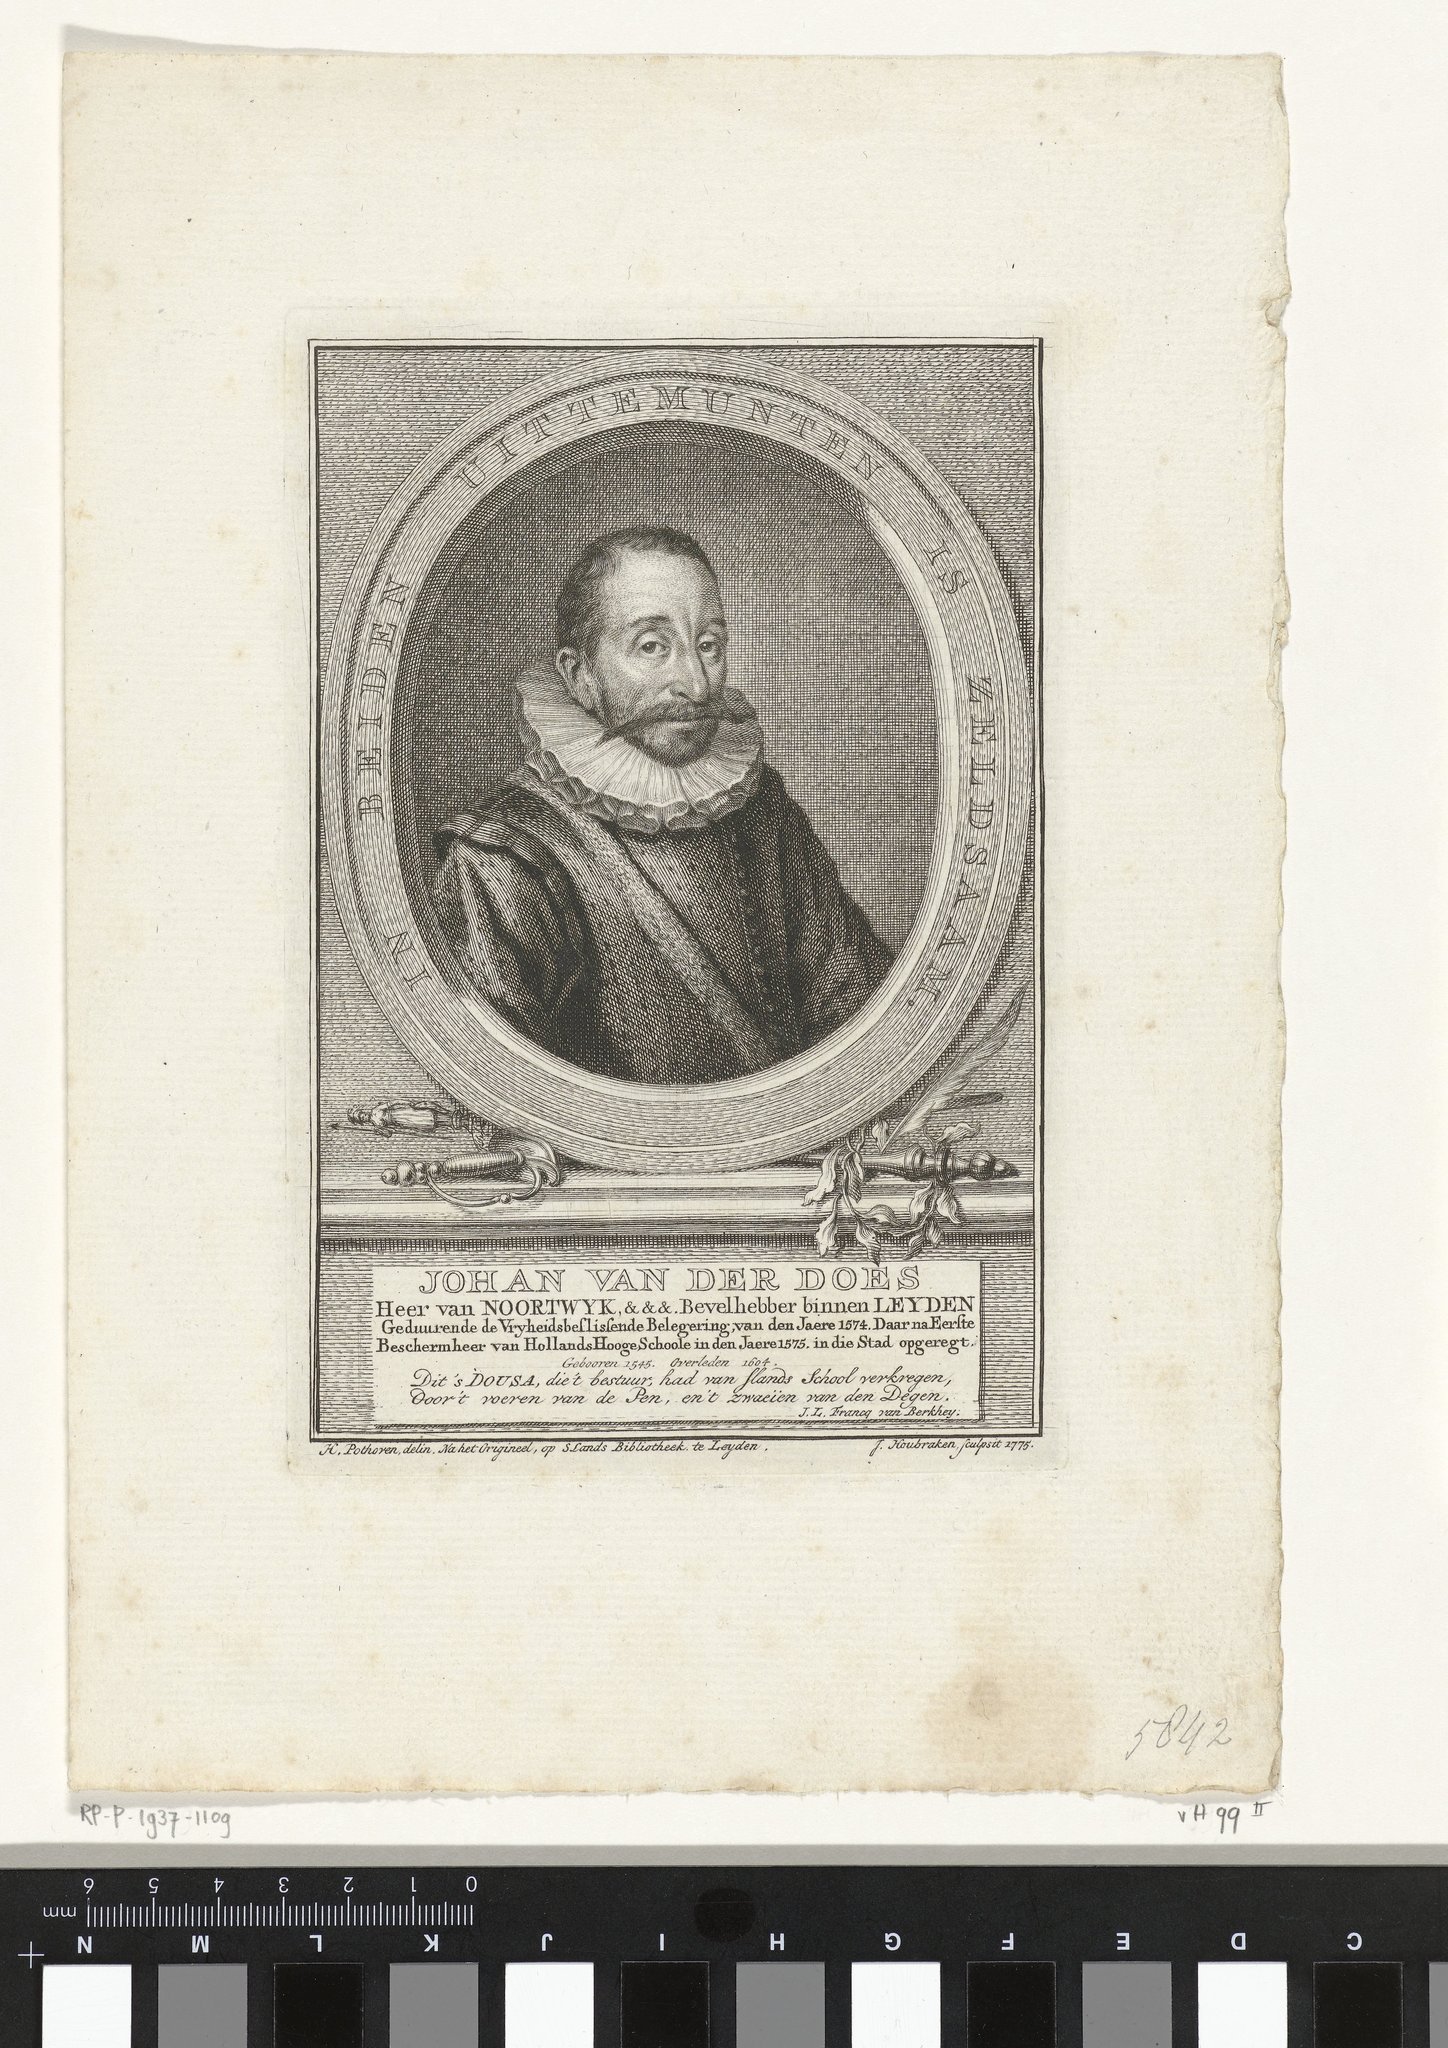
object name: print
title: Johan van der Does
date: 1775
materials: paper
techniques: engraving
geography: amsterdam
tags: bevelhebber, bibliothecaris, bestuurder, jan van der does (heer van noordwijk en kattendijke)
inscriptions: collector's mark: Lugt 2228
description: Buste naar rechts van Johan van der Does, heer van Noordwijk in een ovaal met randschrift in het Nederlands. Het portret rust op een plint waarop een zwaard, een staf, een lauwerkrans en een veer liggen. Onder het portret zijn naam een gegevens in vier regels in het Nederlands en daaronder een tweeregelig vers in het Nederlands.